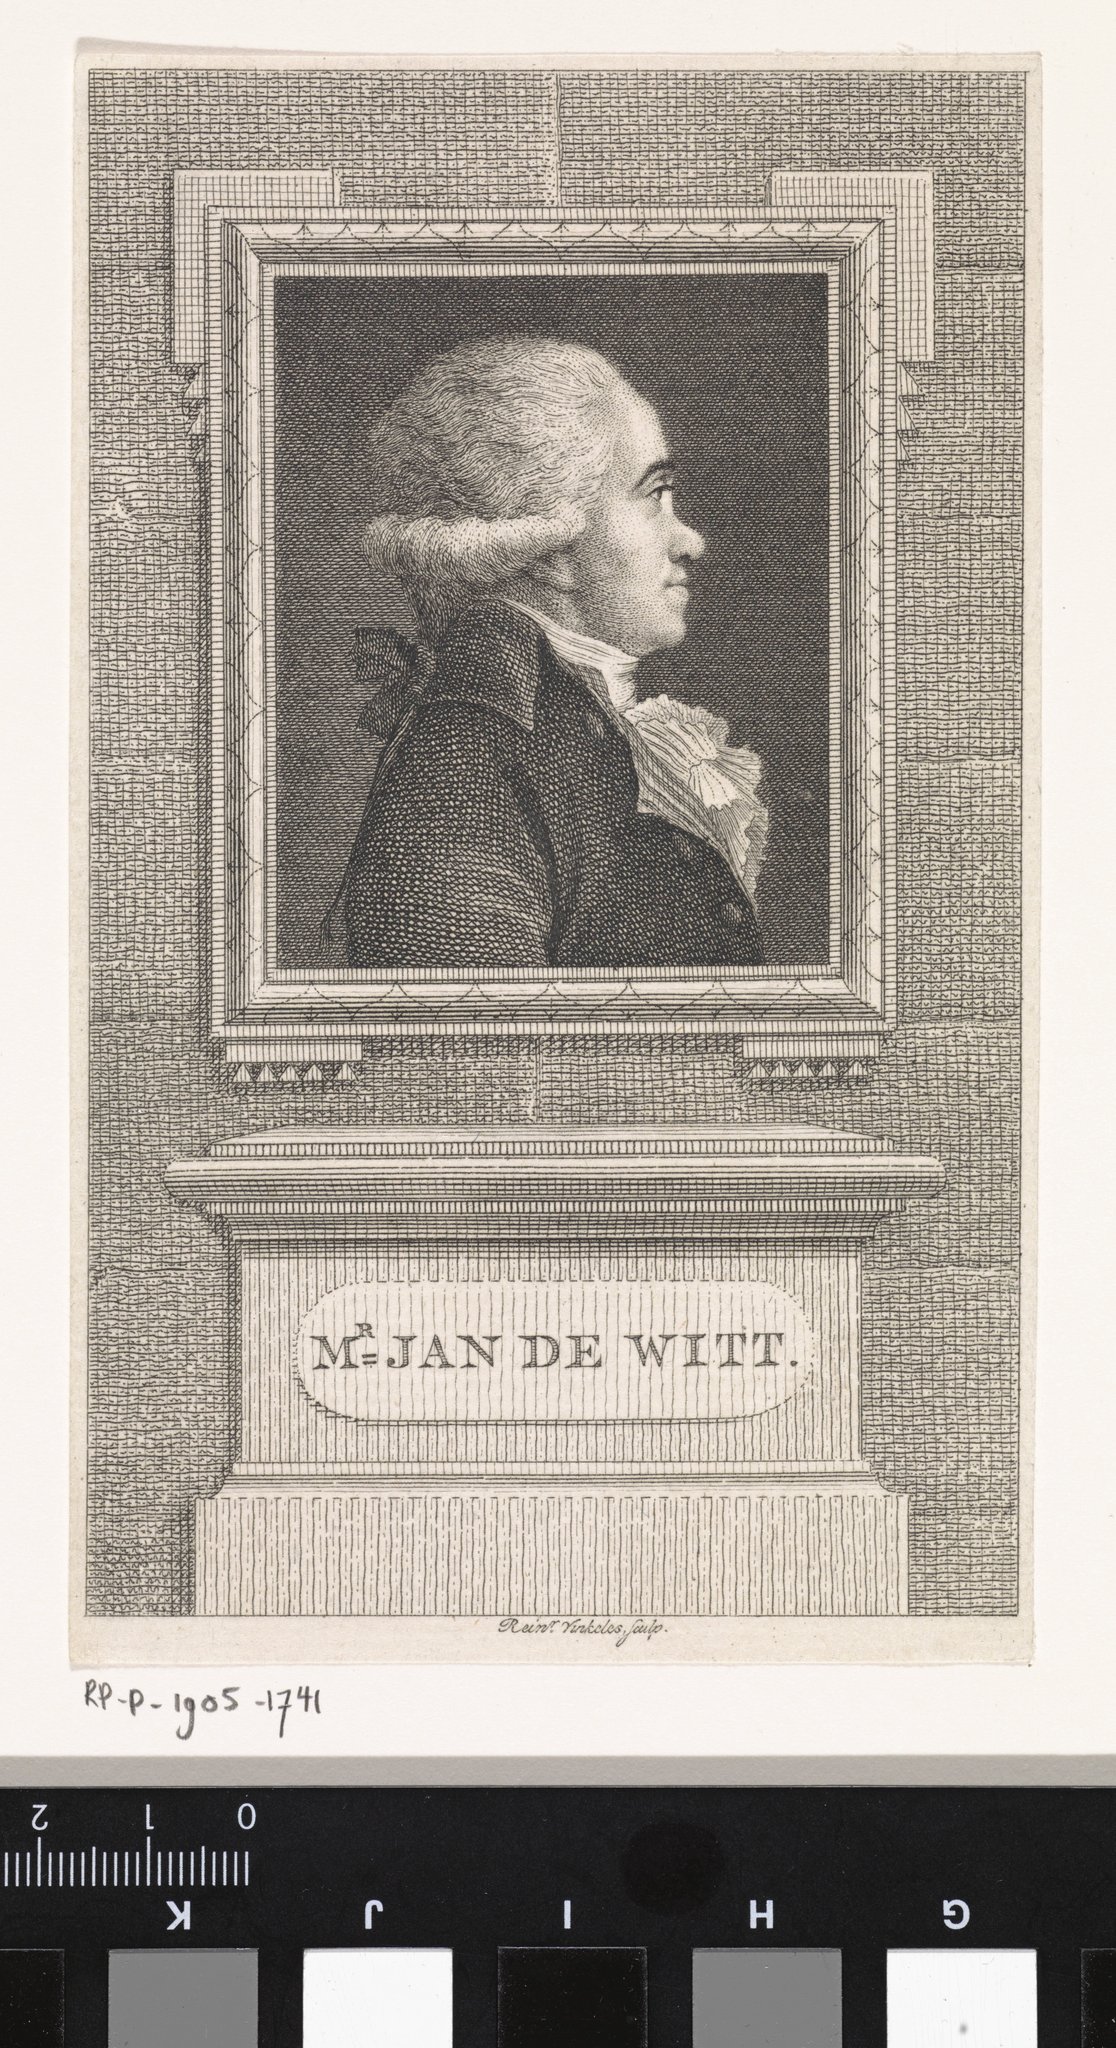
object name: print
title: Portret van Jan de Witt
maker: reinier vinkeles (i)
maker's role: draughtsman, print maker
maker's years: 1741-1816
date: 1786-1809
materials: paper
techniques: engraving, etching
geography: amsterdam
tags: amsterdam, france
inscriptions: collector's mark: Lugt 240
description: Prent ook gebruikt als boekillustratie in: Wagenaar, Jan. Vaderlandsche historie, (...) ten vervolge van Wagenaars Vaderlandsche historie. Dl. 1-43. Amsterdam: Johannes Allart, 1786-1809.